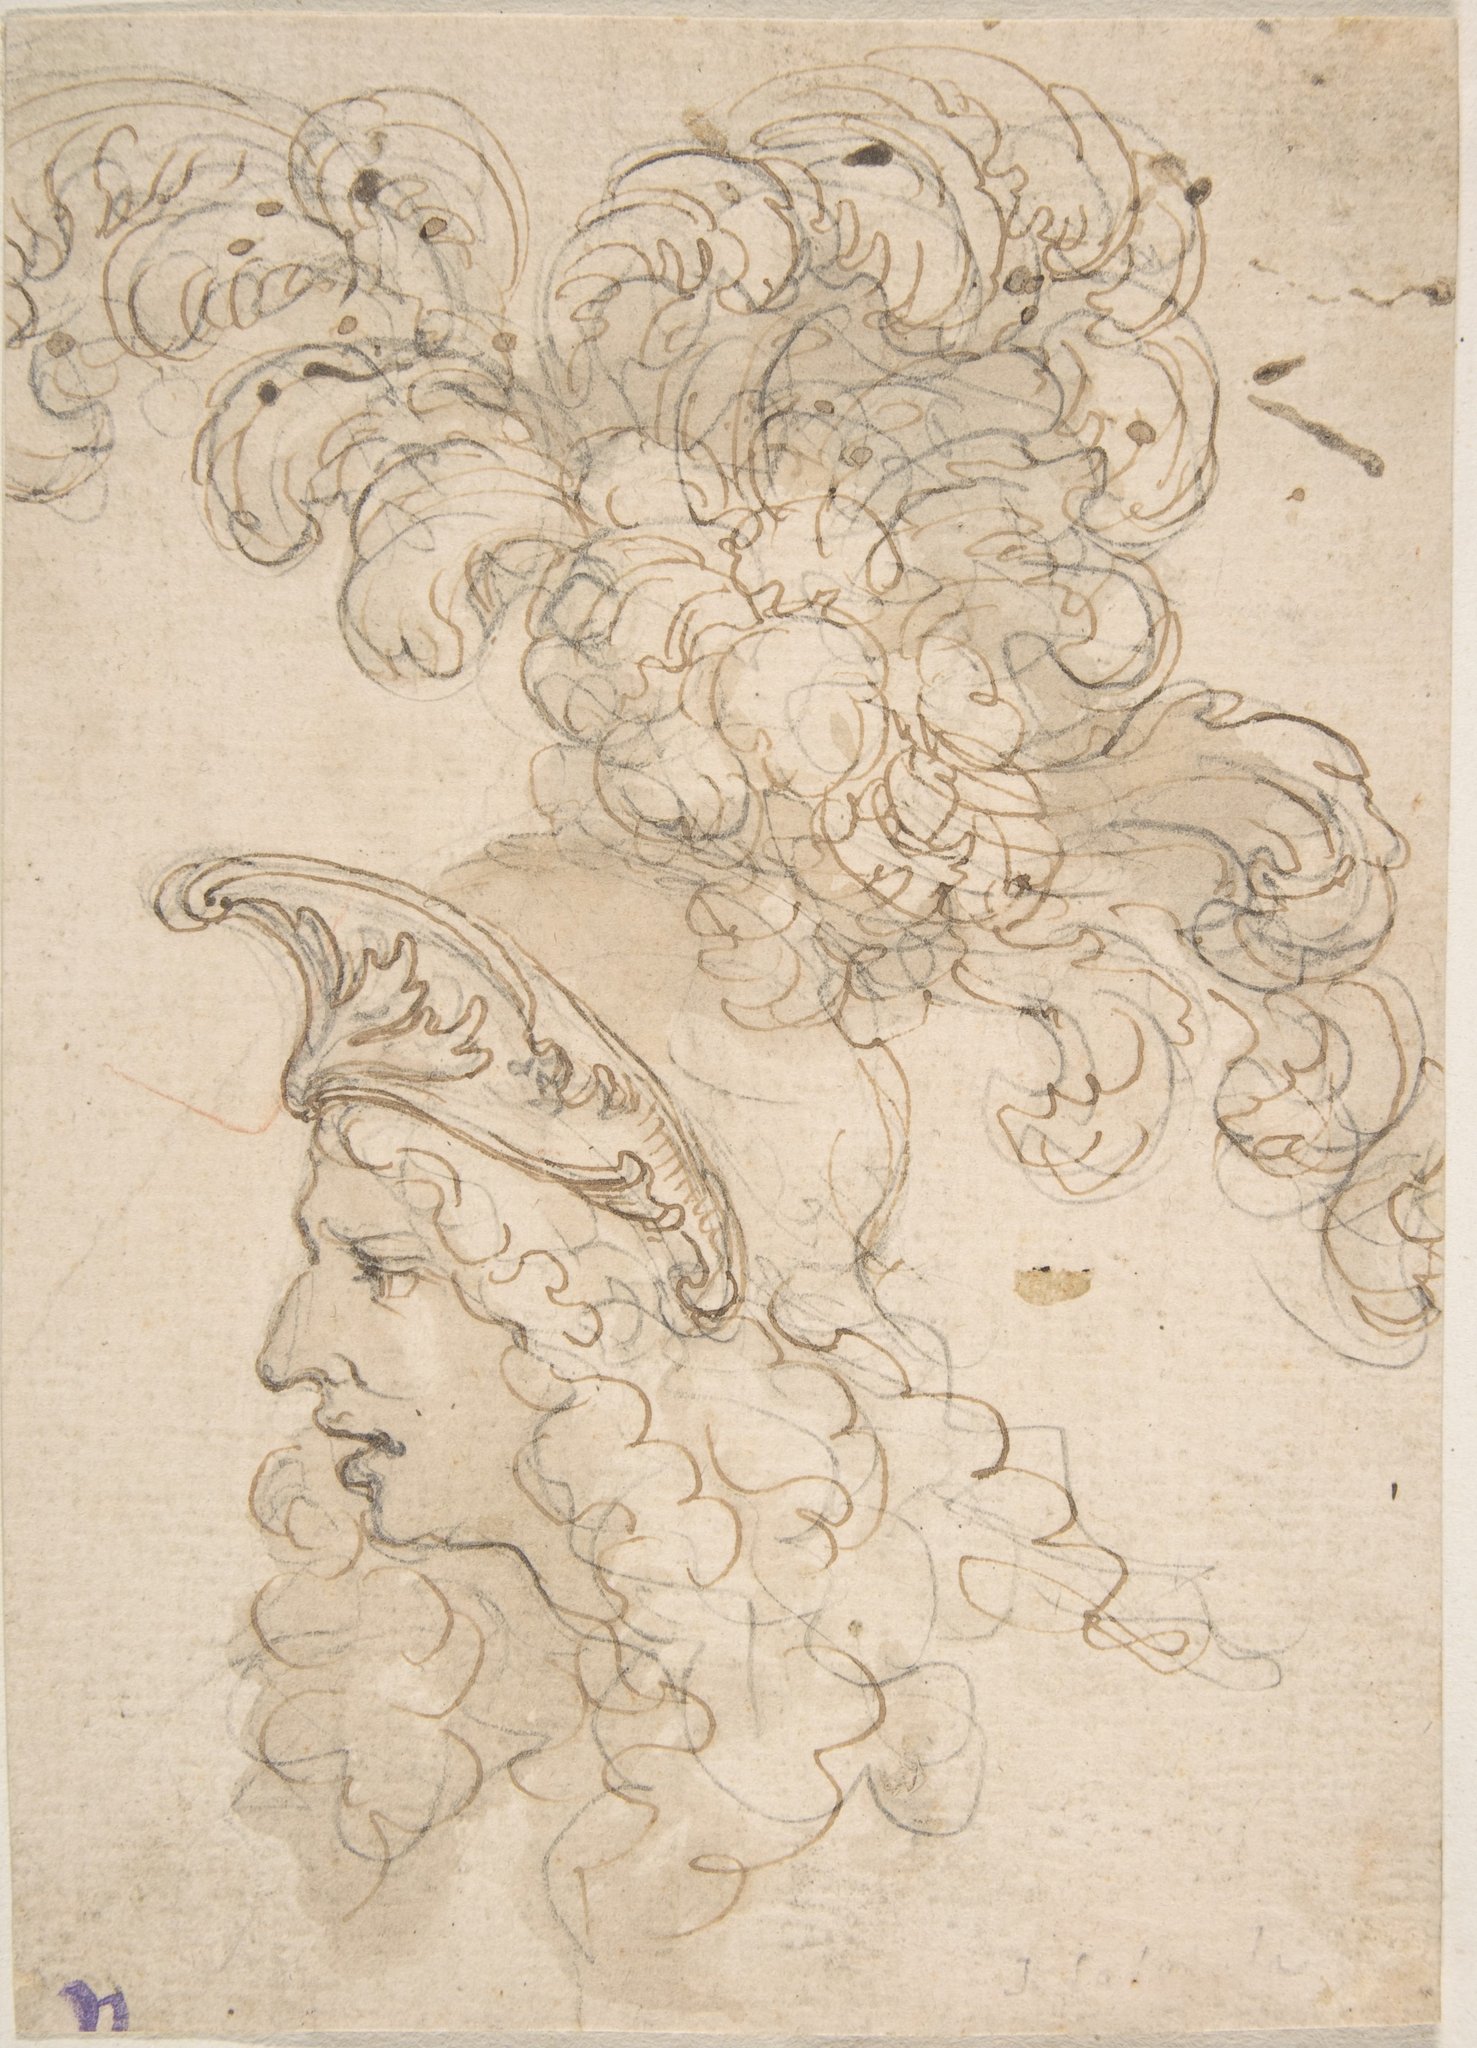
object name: drawing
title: Design for a Helmet with an Elaborate Plume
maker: giovanni battista foggini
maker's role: artist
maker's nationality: italian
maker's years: 1652-1725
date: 1672-1725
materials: chalk, ink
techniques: brush, pen, wash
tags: helmets,men,profiles